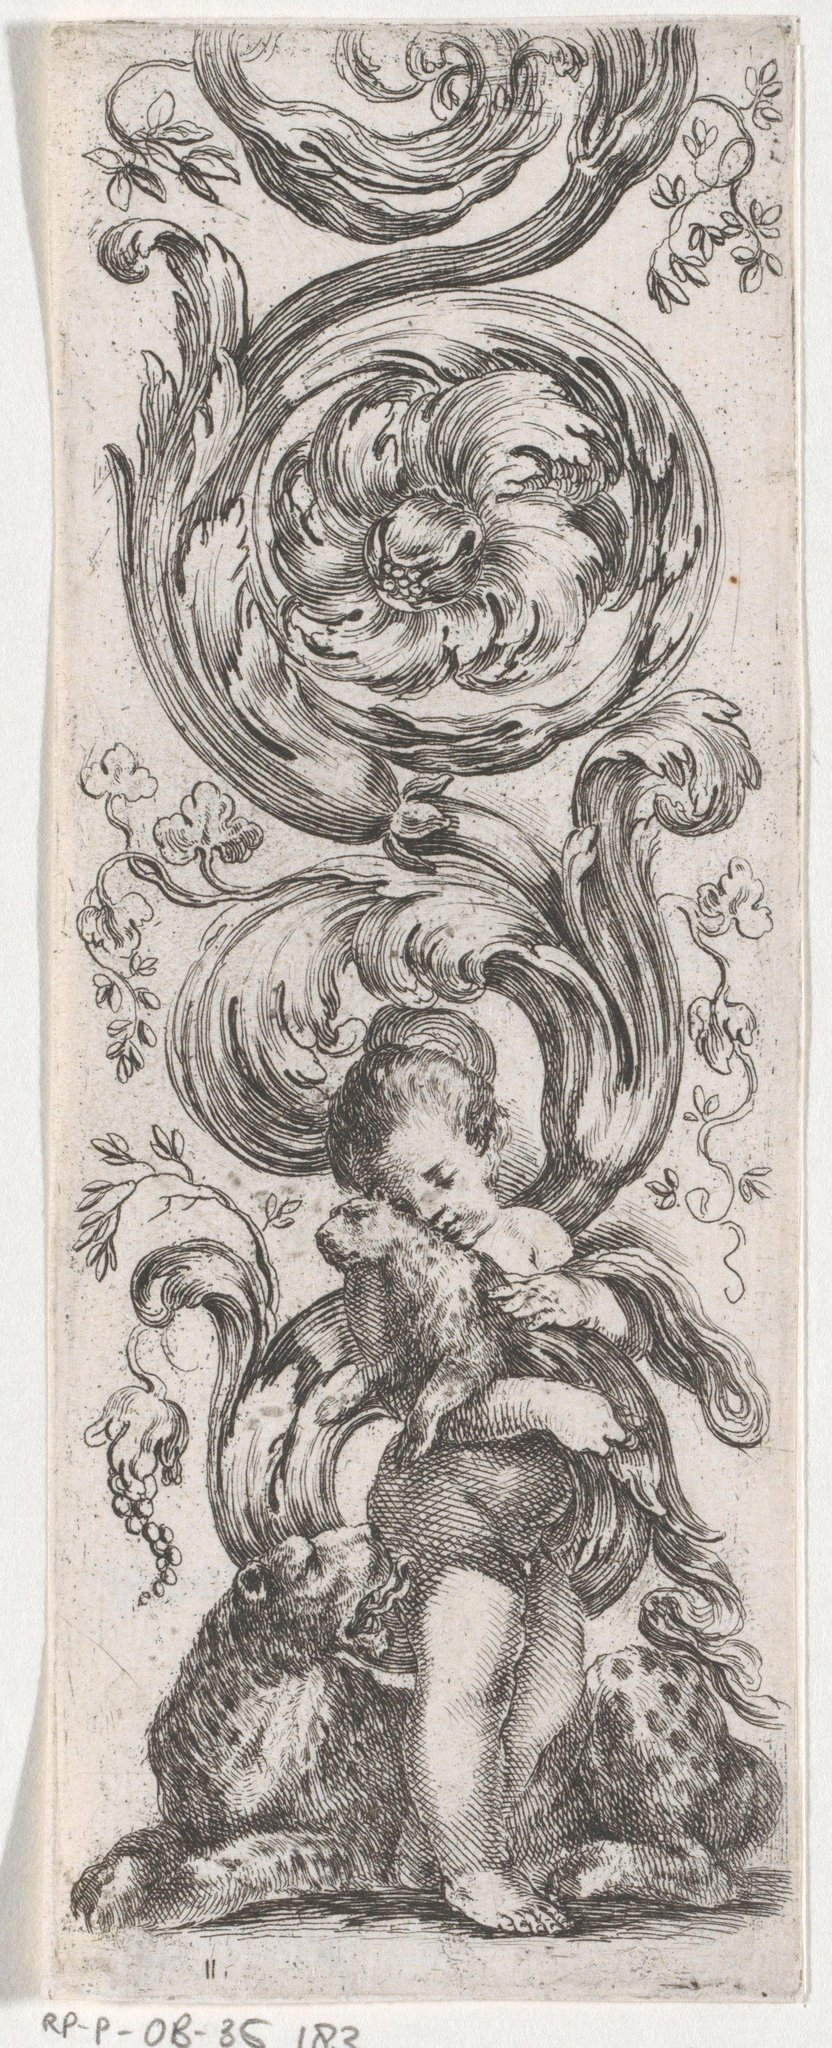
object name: ornament print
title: Ornamenten en grotesken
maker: stefano della bella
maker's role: draughtsman, print maker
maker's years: 1610-1664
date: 1620-1664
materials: paper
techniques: etching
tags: foliage ~ ornament, beasts of prey, predatory animals: panther, child, child playing with animals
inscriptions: collector's mark: Lugt 240